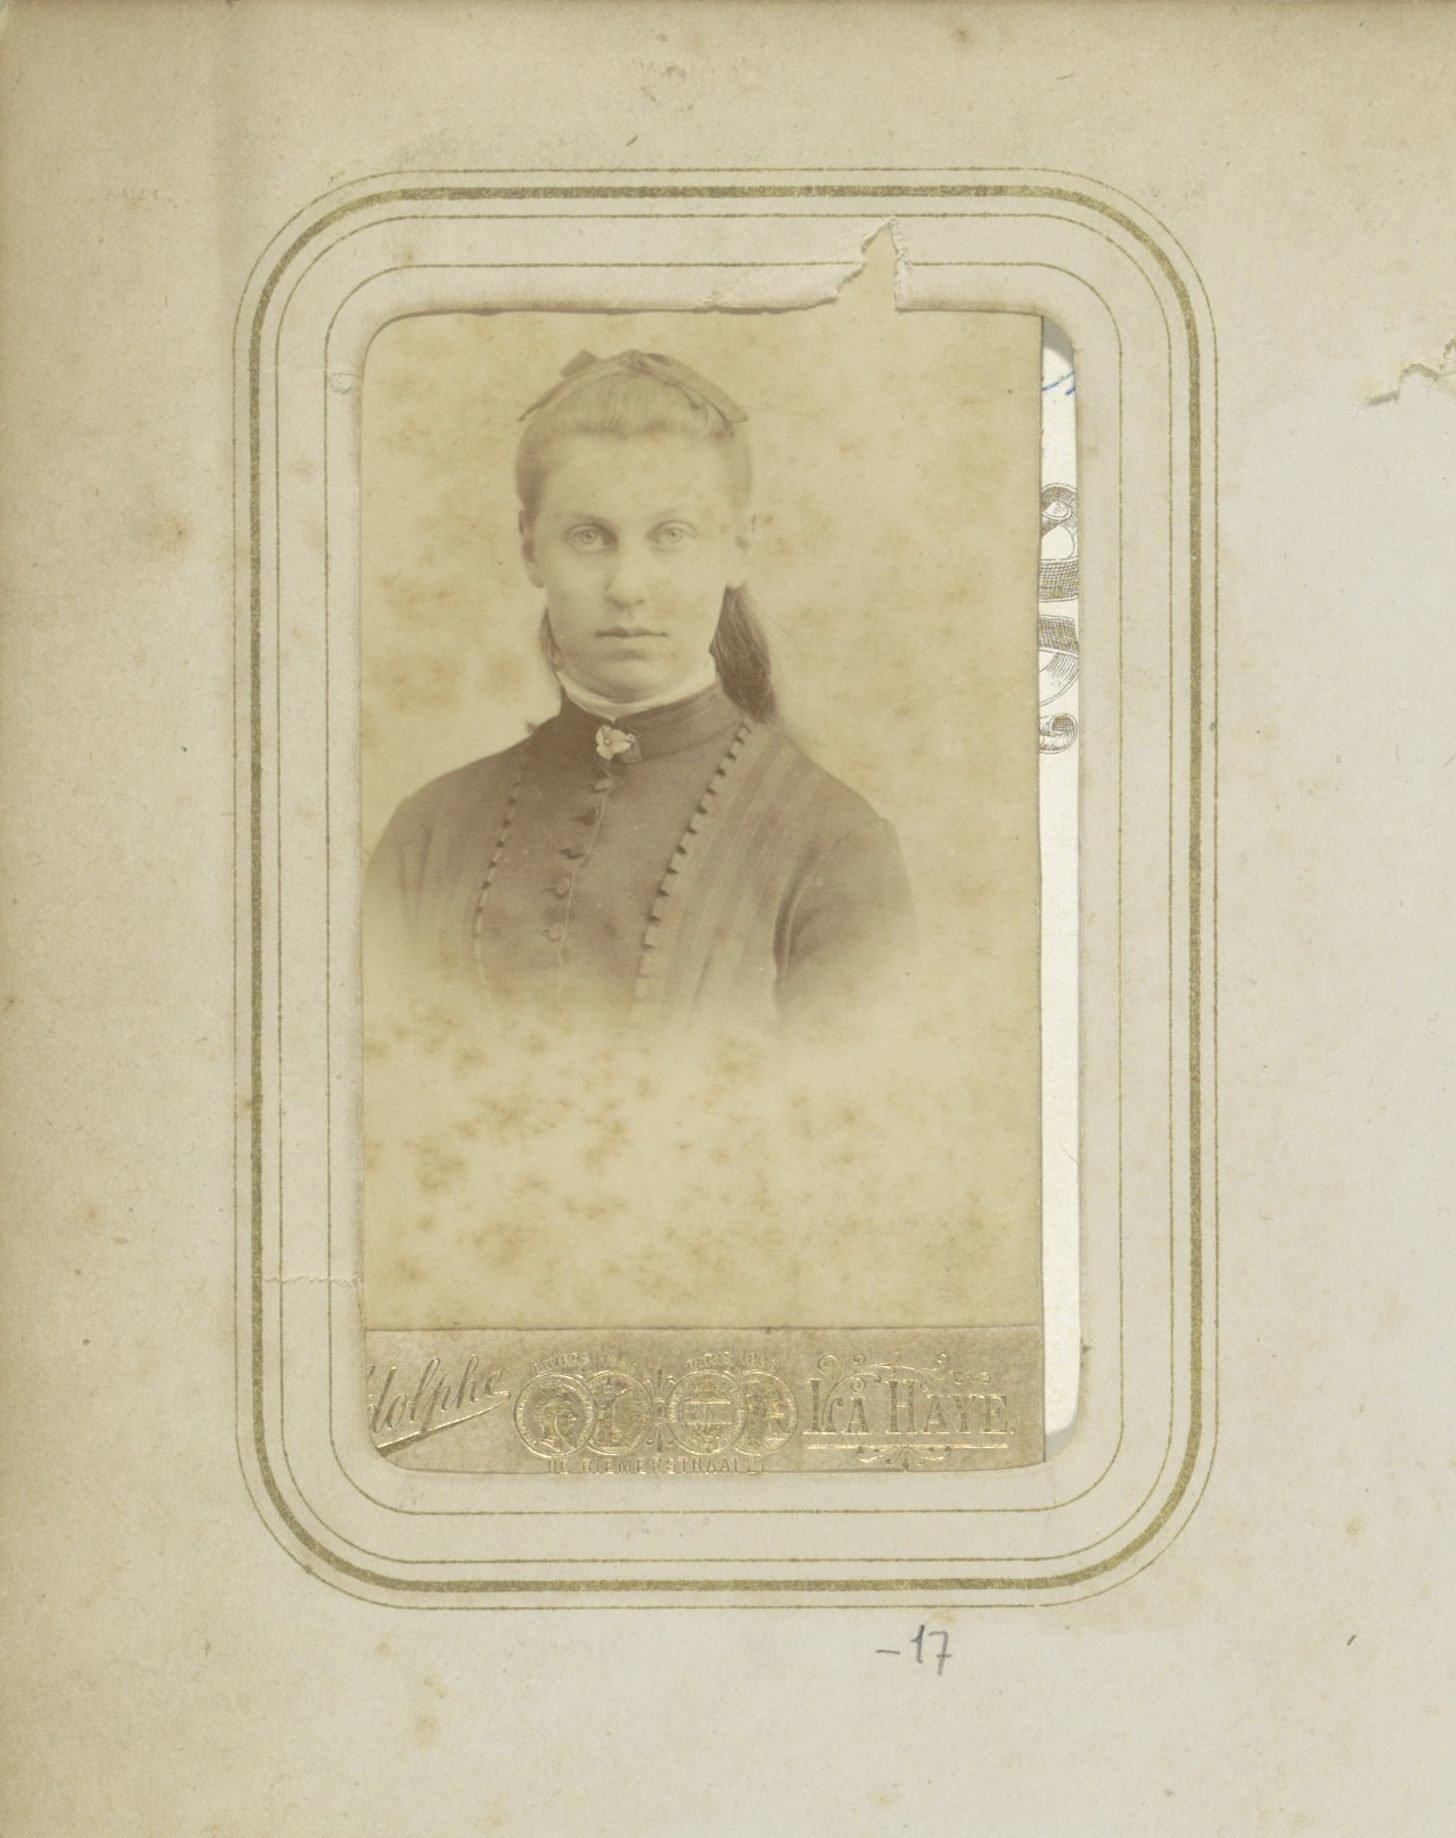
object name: carte de visite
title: Portret van een vrouw met een halssieraad en opgestoken haar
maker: adolphe zimmermans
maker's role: fotograaf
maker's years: 1858-1922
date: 1913-1922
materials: cardboard, photographic support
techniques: albumen print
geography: the hague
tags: historical persons, styles of hairdress - aa - ~ women, brooch, agraffe, clasp, family, relationship, descent, the hague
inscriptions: address: ‘De Riemerstraat 21 La Haye’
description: Onderdeel van Familiealbum van H.W.F. Ligtenberg en L.M. Swart met 149 foto's en cartes-de-visite.